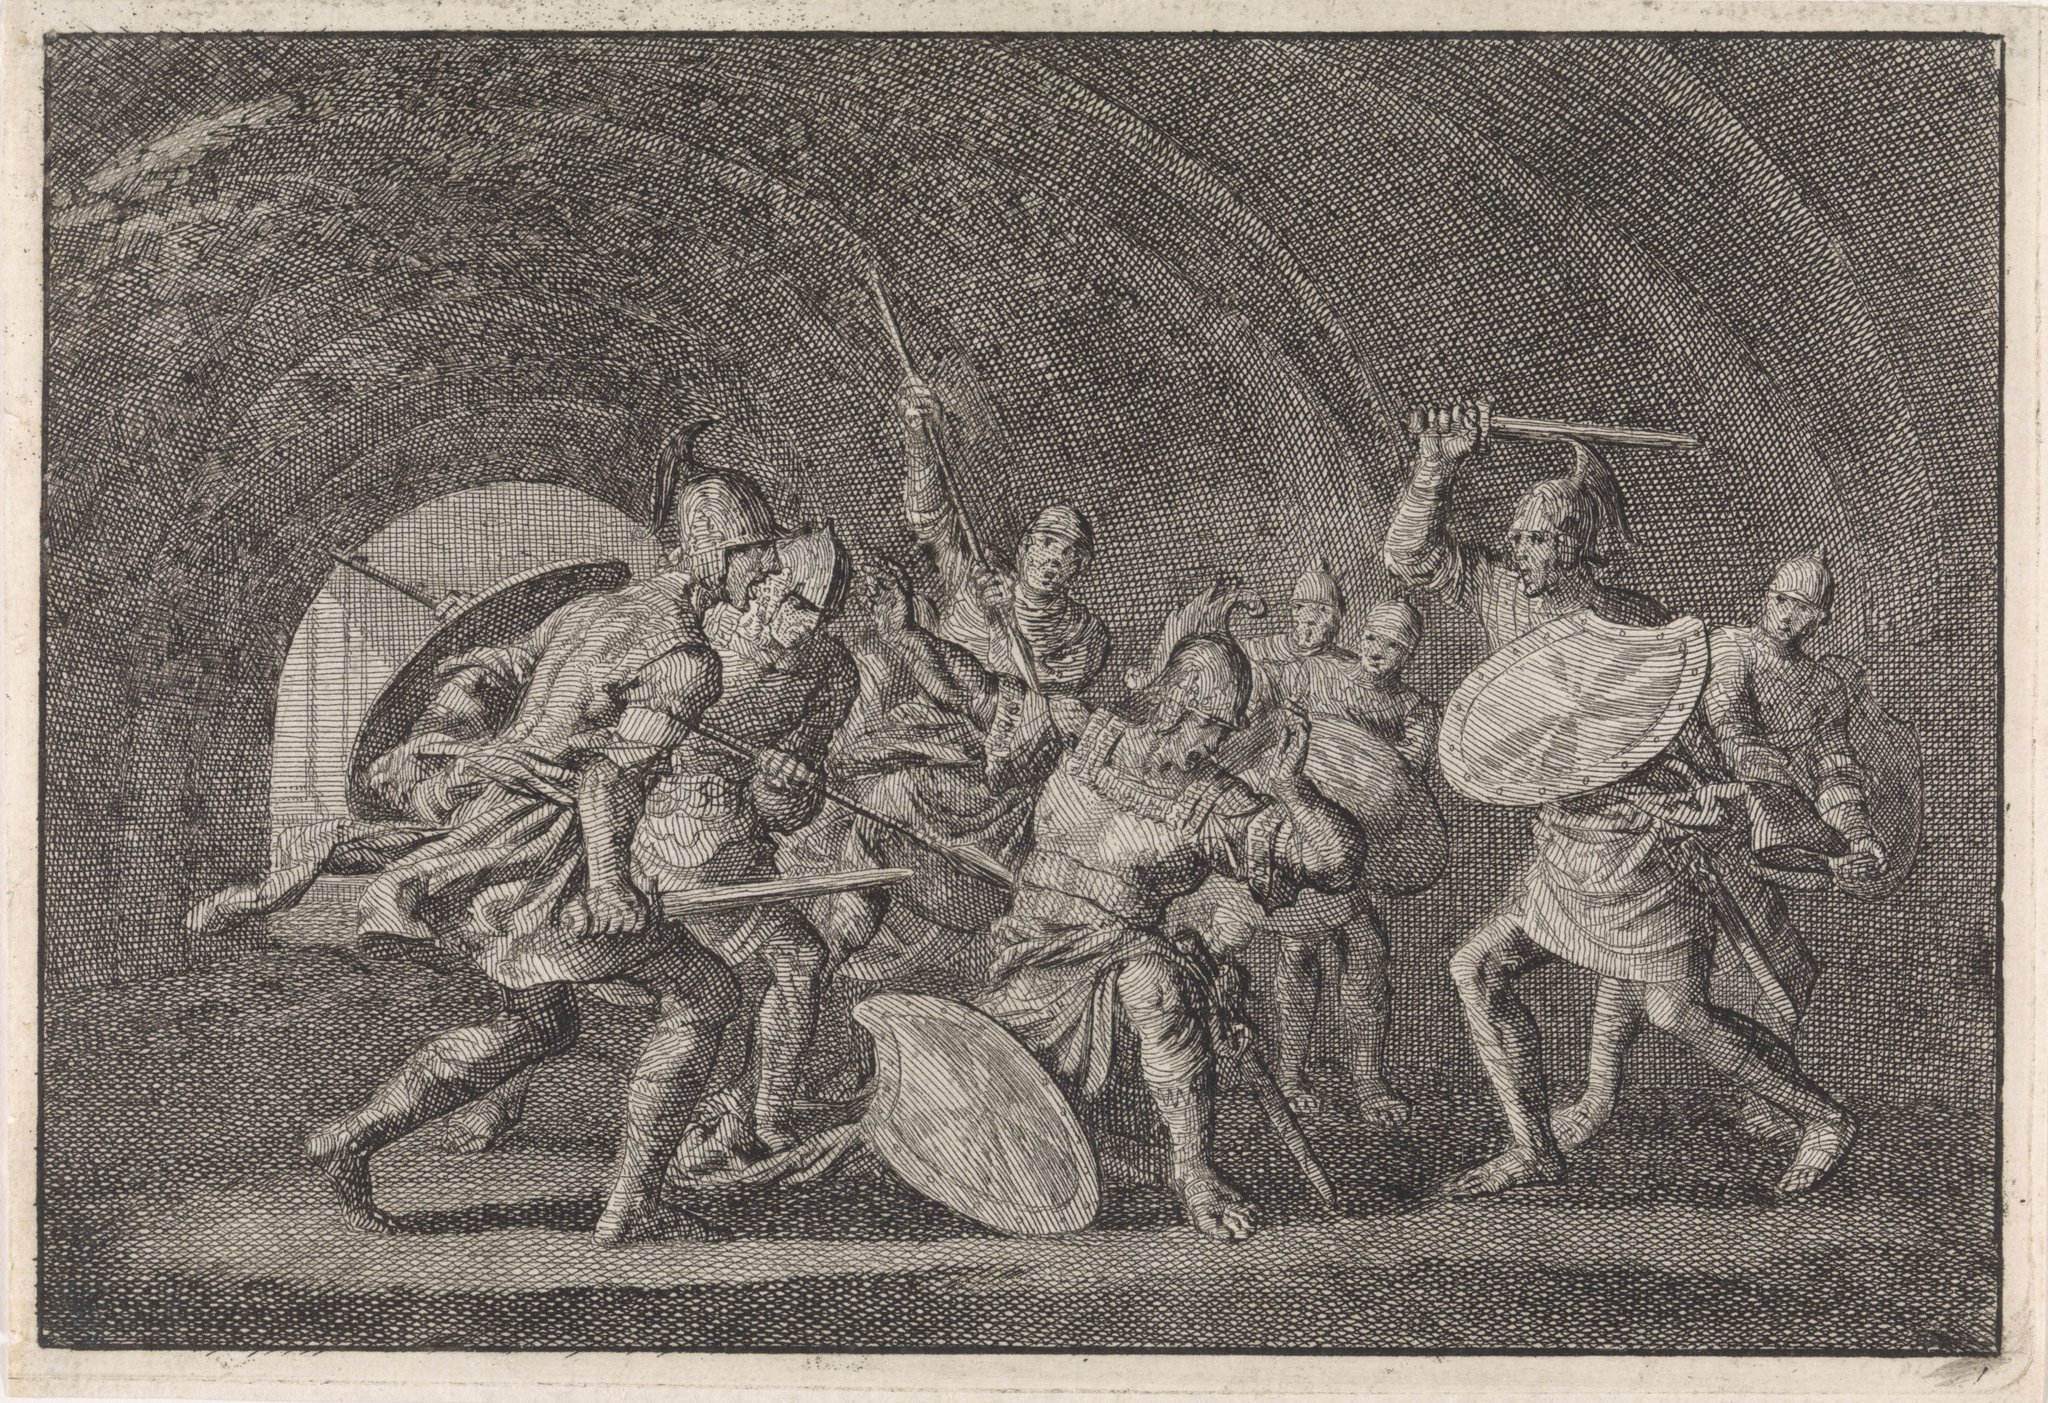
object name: print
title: Antigonus, zoon van Hyrkanus, in een gewelf vermoord door de lijfwacht van zijn broer Aristobulus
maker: jan luyken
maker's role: draughtsman, print maker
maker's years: 1649-1712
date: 1704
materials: paper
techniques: etching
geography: amsterdam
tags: attempt, political murder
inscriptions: collector's mark: Lugt 2228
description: Prent ook gebruikt als boekillustratie in: Josephus, Flavius. Alle de Werken, 2 delen. Amsterdam: Pieter Mortier, 1704, dl. 1, p. 325.